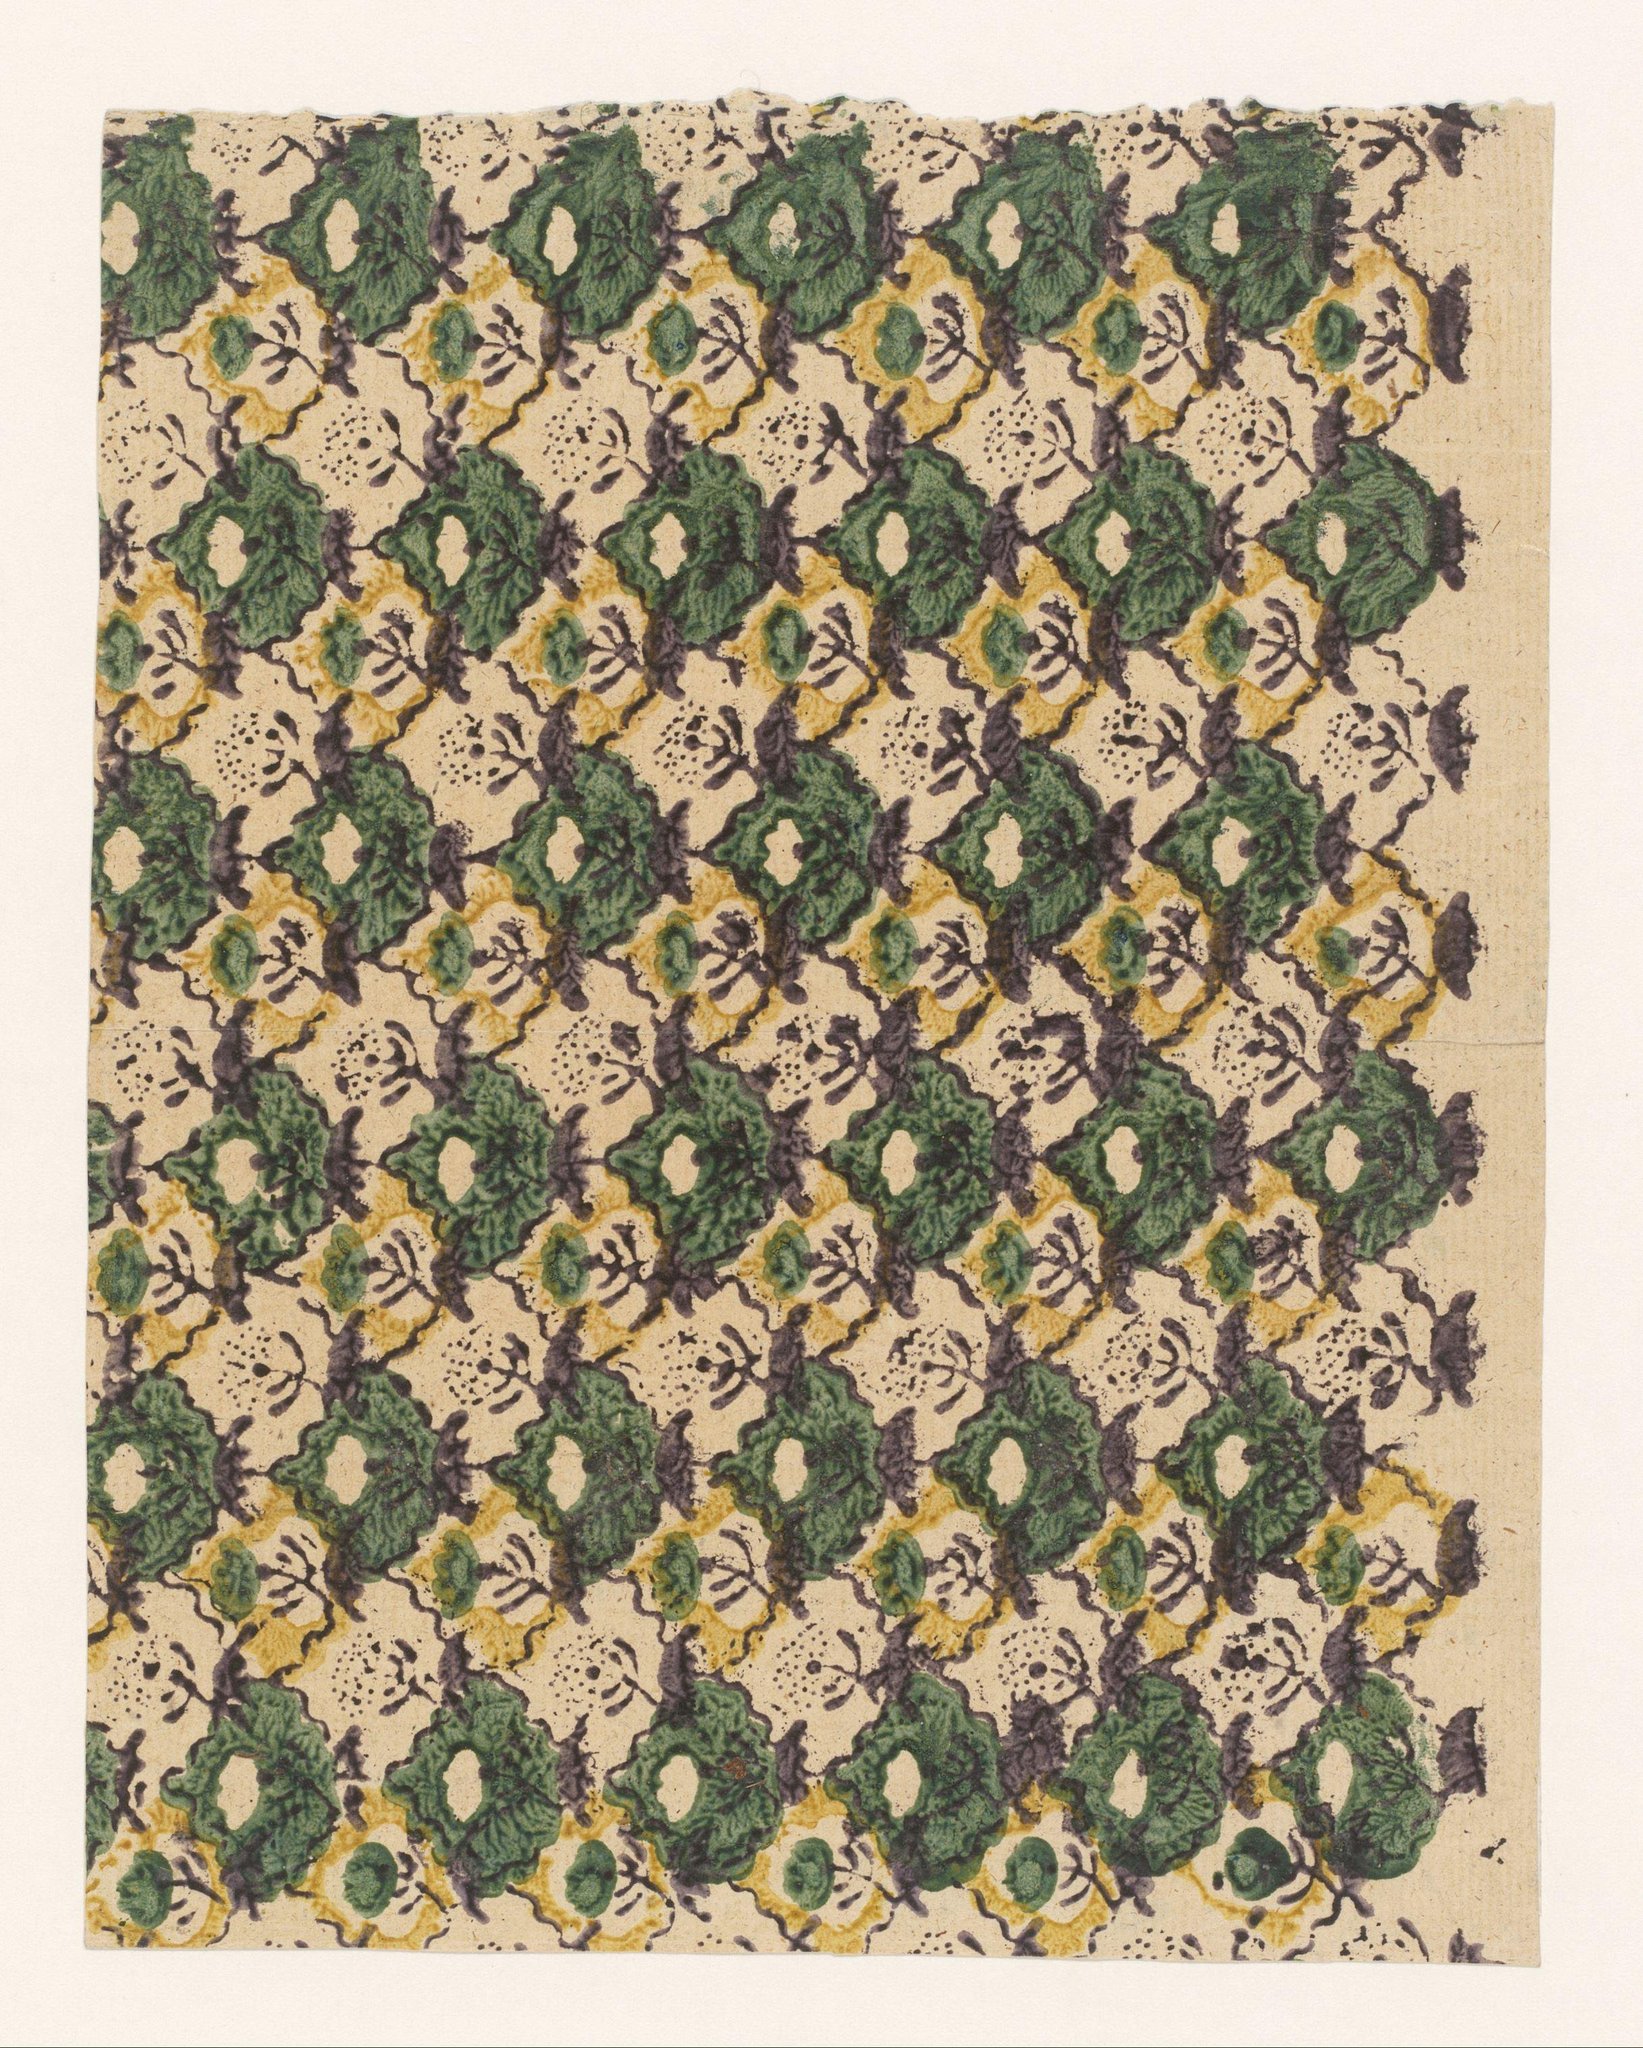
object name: printed paper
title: Blad met strooipatroon van bloemmotief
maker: Anonymous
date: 1750-1900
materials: paper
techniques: printing block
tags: ornament derived from plant forms